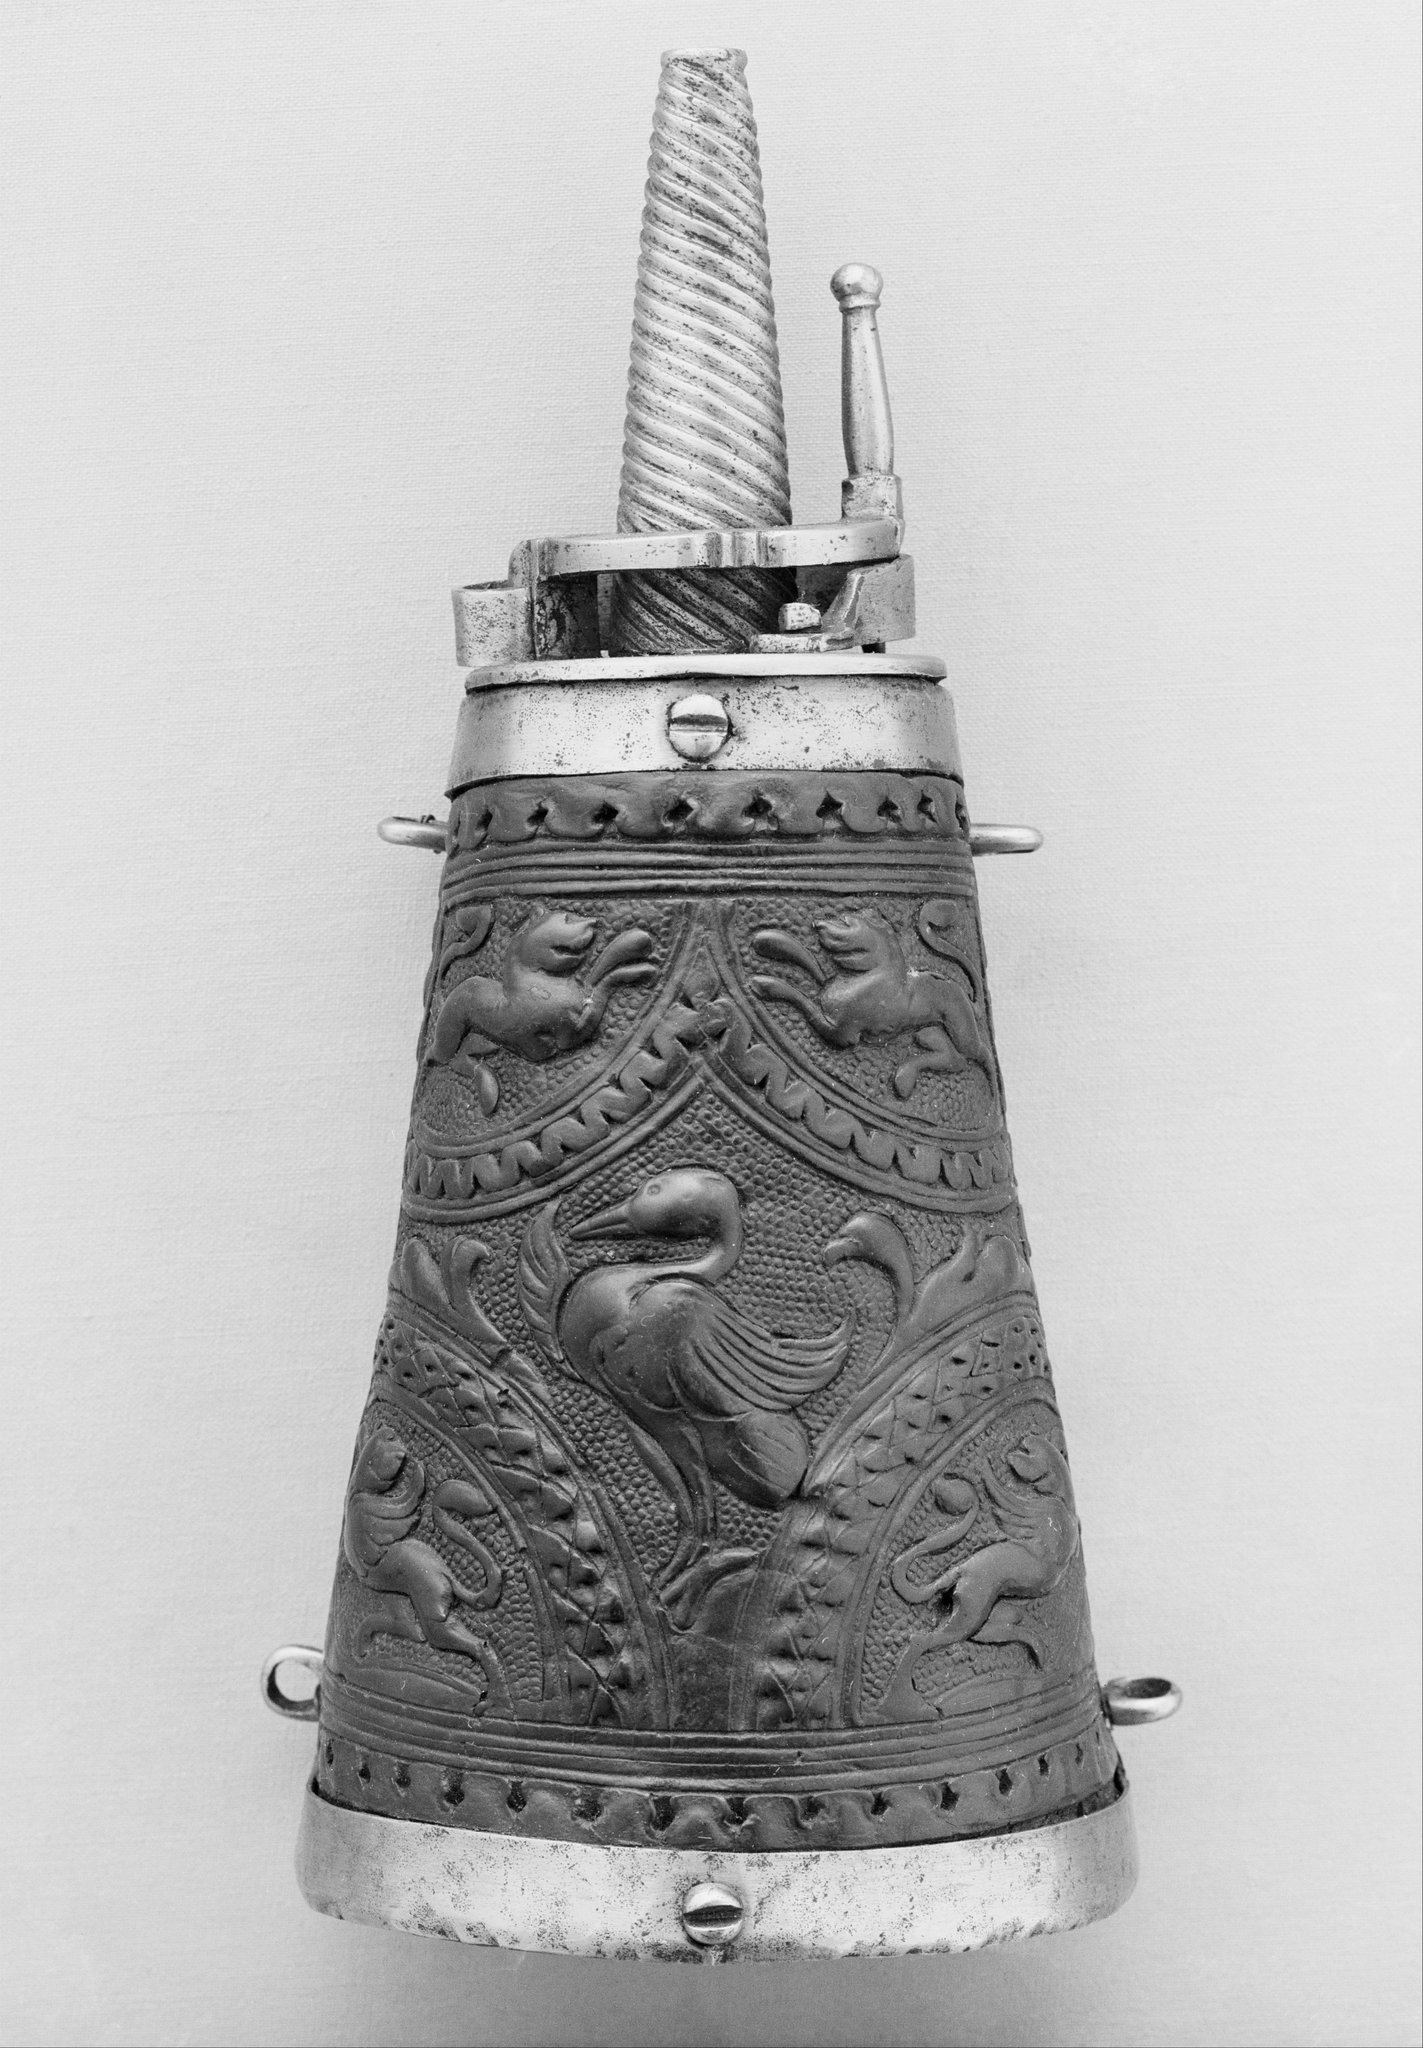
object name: powder flask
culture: italian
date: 1551-1600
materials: leather, pigment, steel, wood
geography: italy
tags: birds,griffins,lions